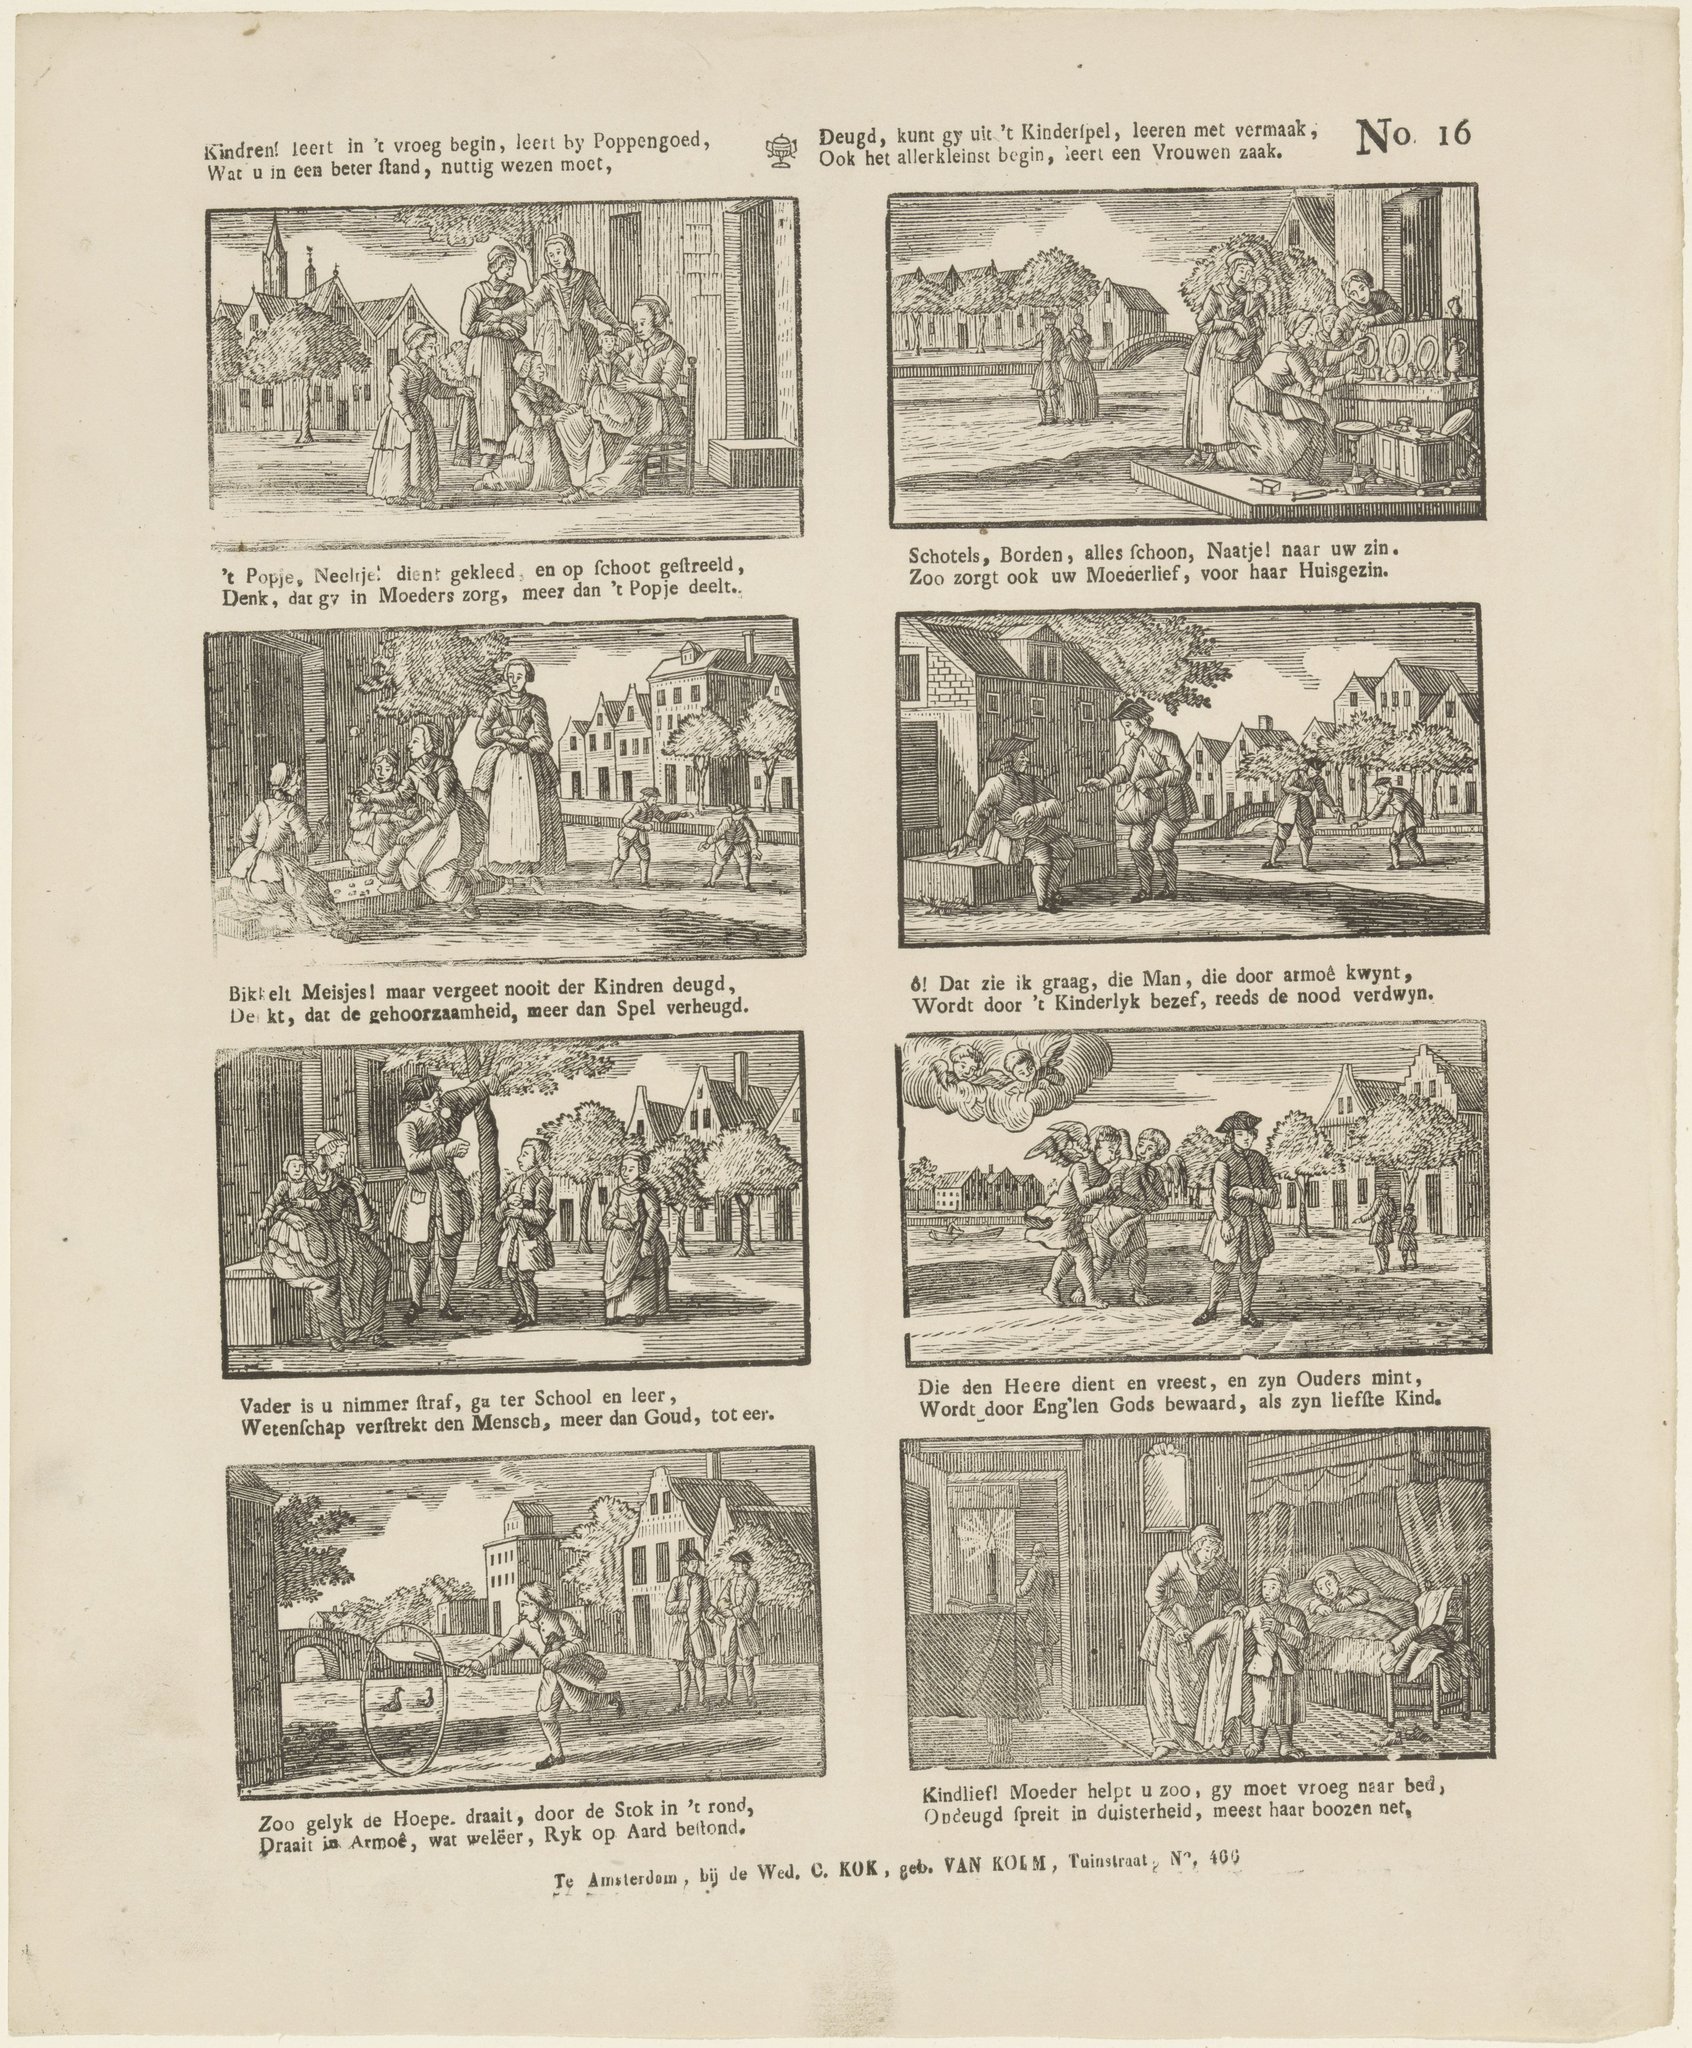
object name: popular print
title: Kinderen! leert in 't vroeg begin, leert by poppengoed, / Wat u in een beter stand, nuttig wezen moet, / Deugd, kunt gy uit 't kinderspel, leeren met vermaak, / Ook het allerkleinst begin, leert een vrouwen zaak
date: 1842-1866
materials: paper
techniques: letterpress printing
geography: netherlands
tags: children's games and plays, (playing with) dolls, games using special objects (marbles, top, hoop, etc.)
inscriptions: collector's mark: Lugt 2760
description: Blad met 8 voorstellingen van kinderspelen, waaronder hoepelen en met poppen spelen. Onder elke afbeelding een tweeregelig vers. Genummerd rechtsboven: No. 16.